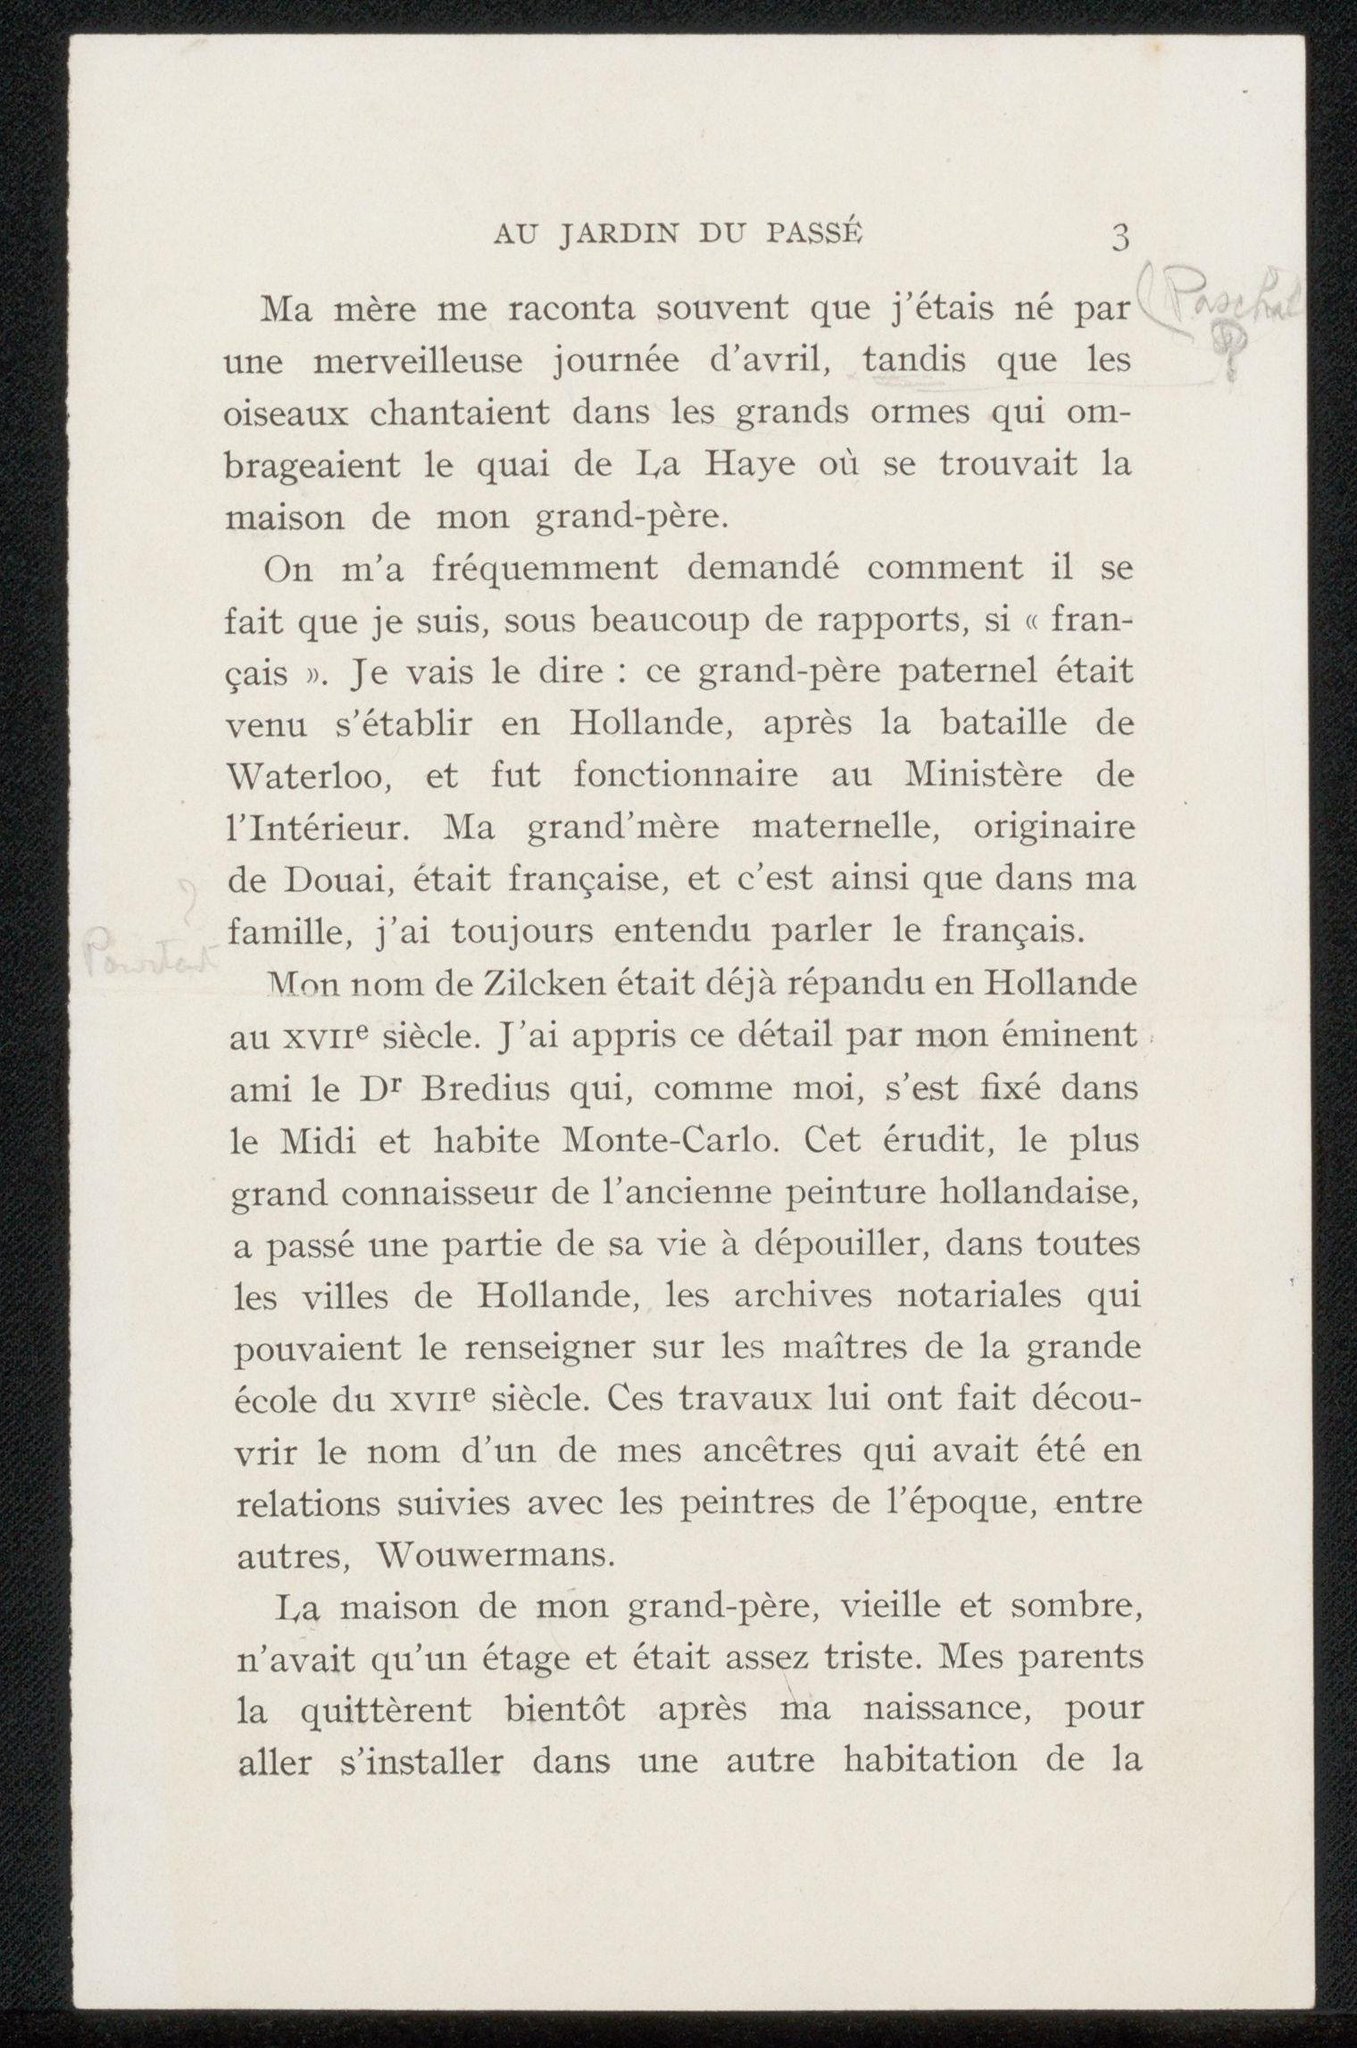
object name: tekst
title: Tekst uit archief Philip Zilcken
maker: philip zilcken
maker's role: draughtsman, painter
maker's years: 1857-1930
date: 1929-1930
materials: ink, paper, pencil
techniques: printing, writing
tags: the hague, painter, draughtsman, philip zilcken